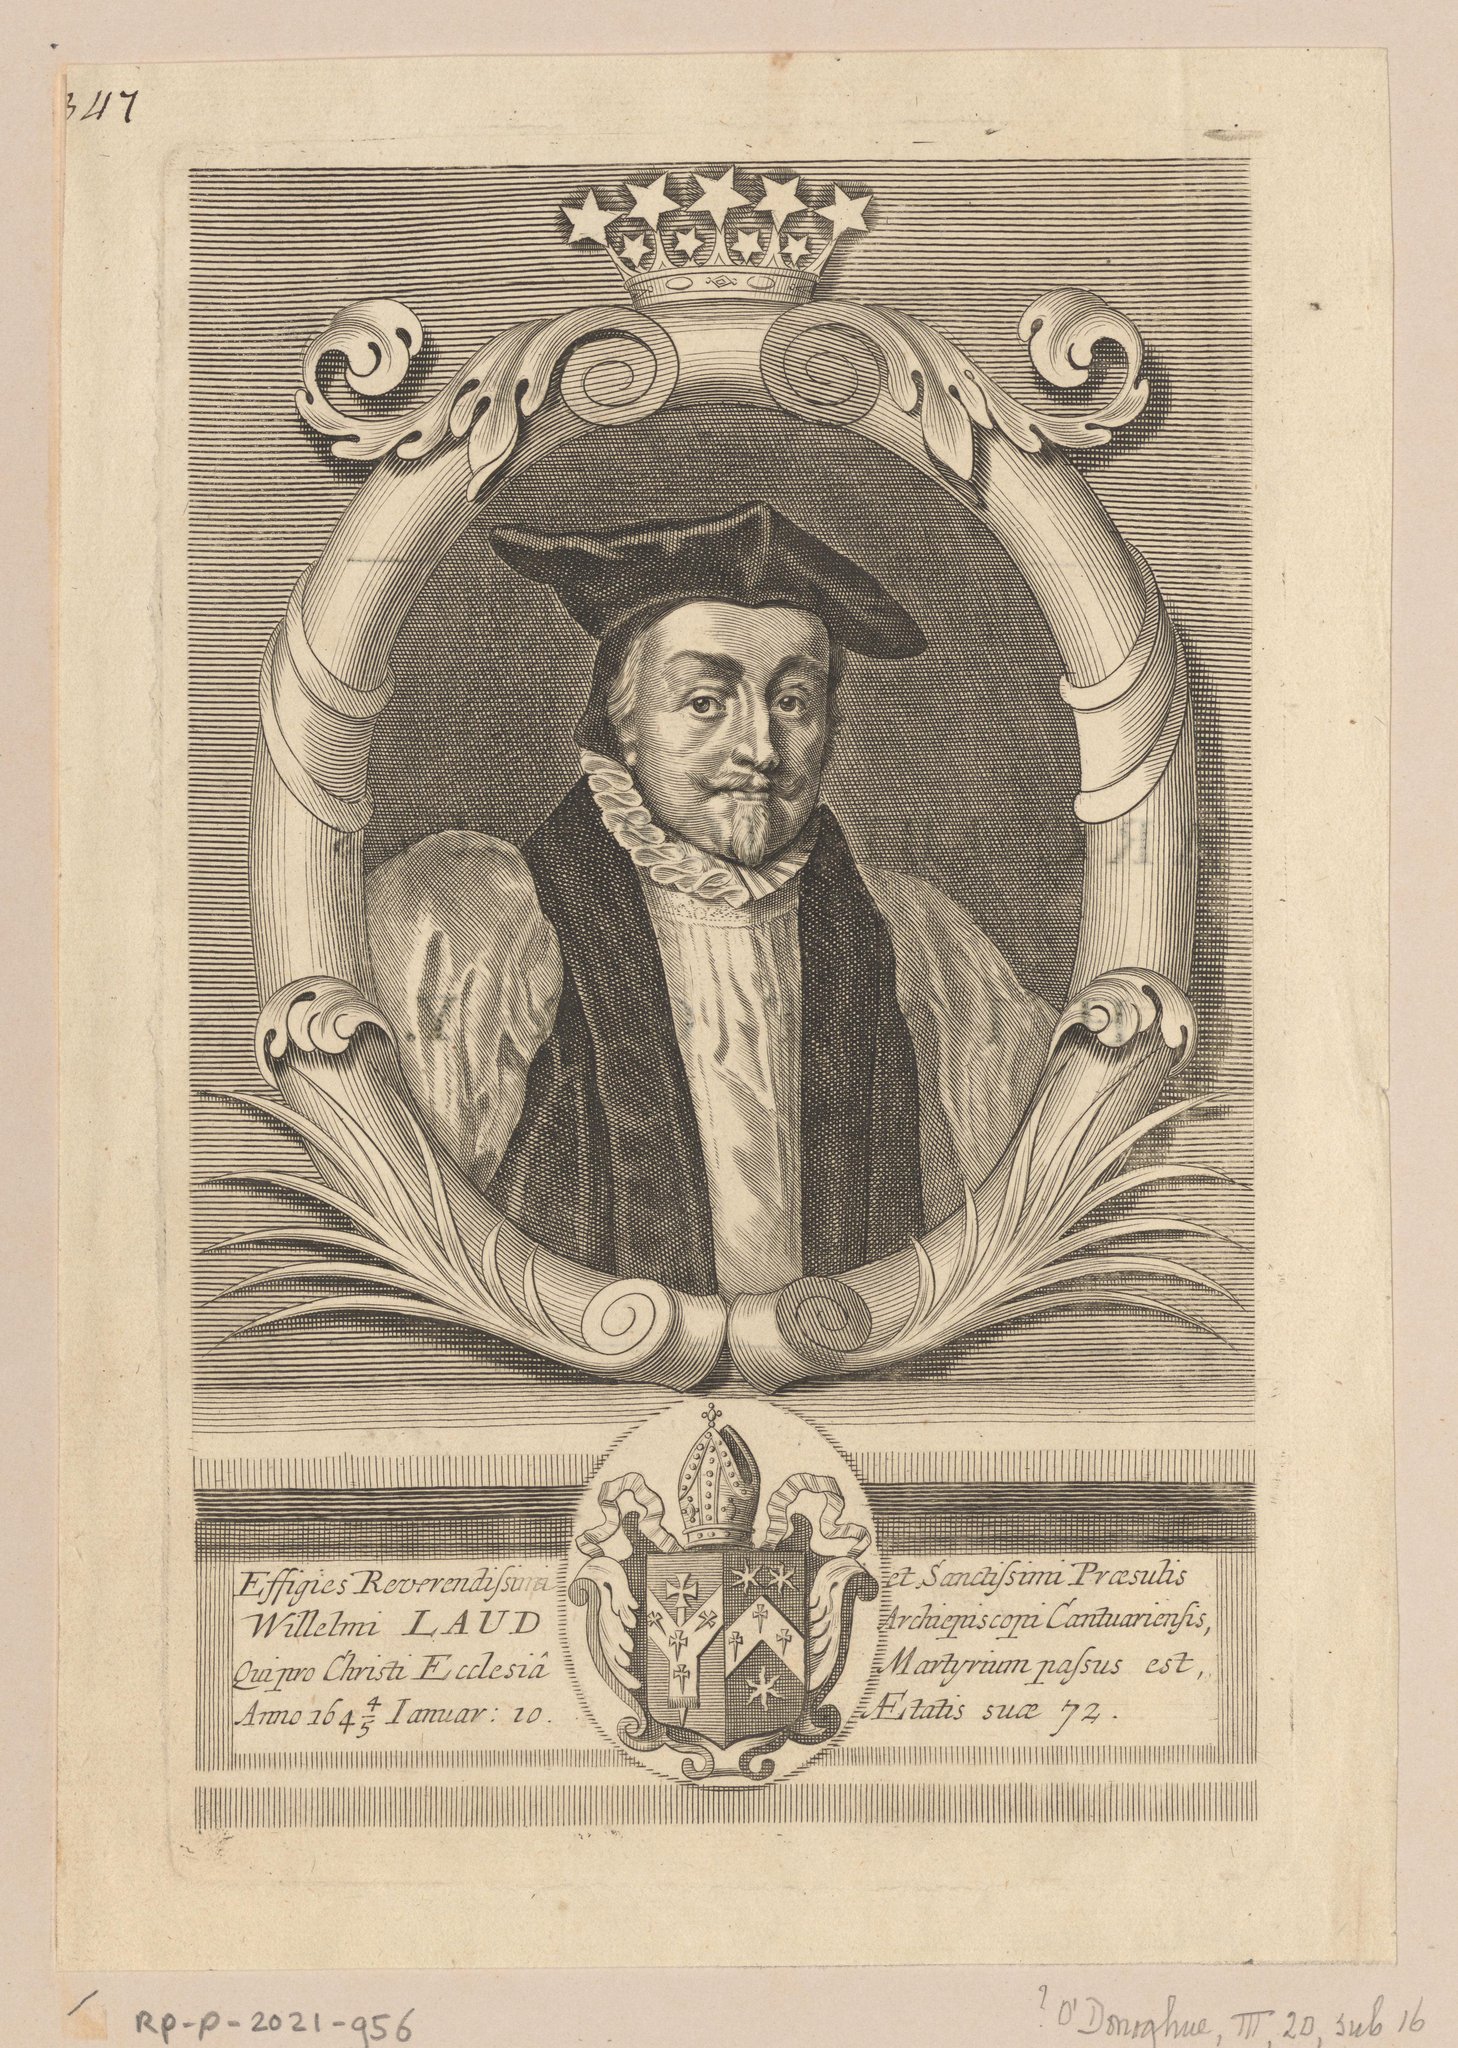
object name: book illustration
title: Portret van William Laud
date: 1695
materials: paper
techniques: engraving, letterpress printing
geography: london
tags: clergyman, crown (symbol of sovereignty), ornament ~ medallion, historical persons, armorial bearing, heraldry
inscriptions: number: ‘347’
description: Prent uit: Laud, William. The History of the Troubles and Tryal of the Most Reverend Father in God, and Blessed Martyr, William Laud (...). London: Richard Chiswell, 1695.